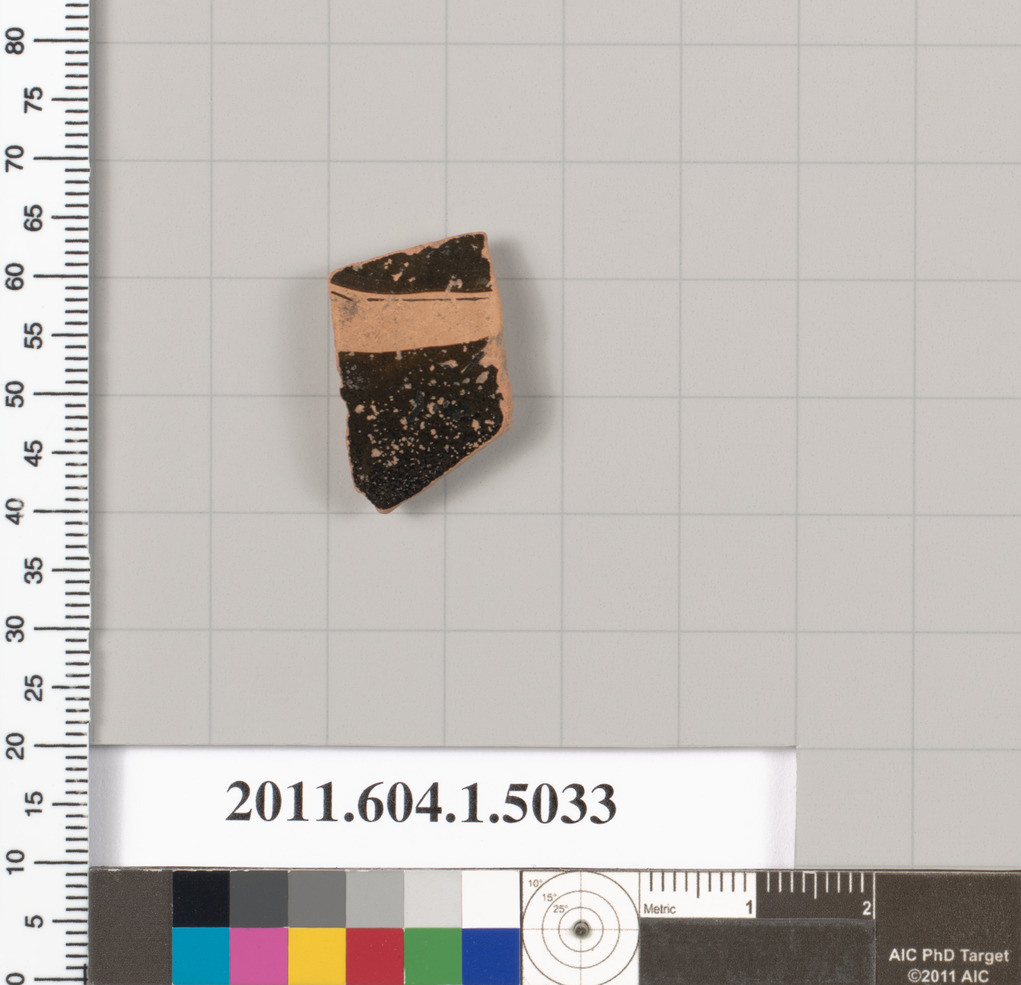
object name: kylix fragment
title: Terracotta fragment of a kylix (drinking cup)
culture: greek, attic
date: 500-480 BCE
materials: terracotta